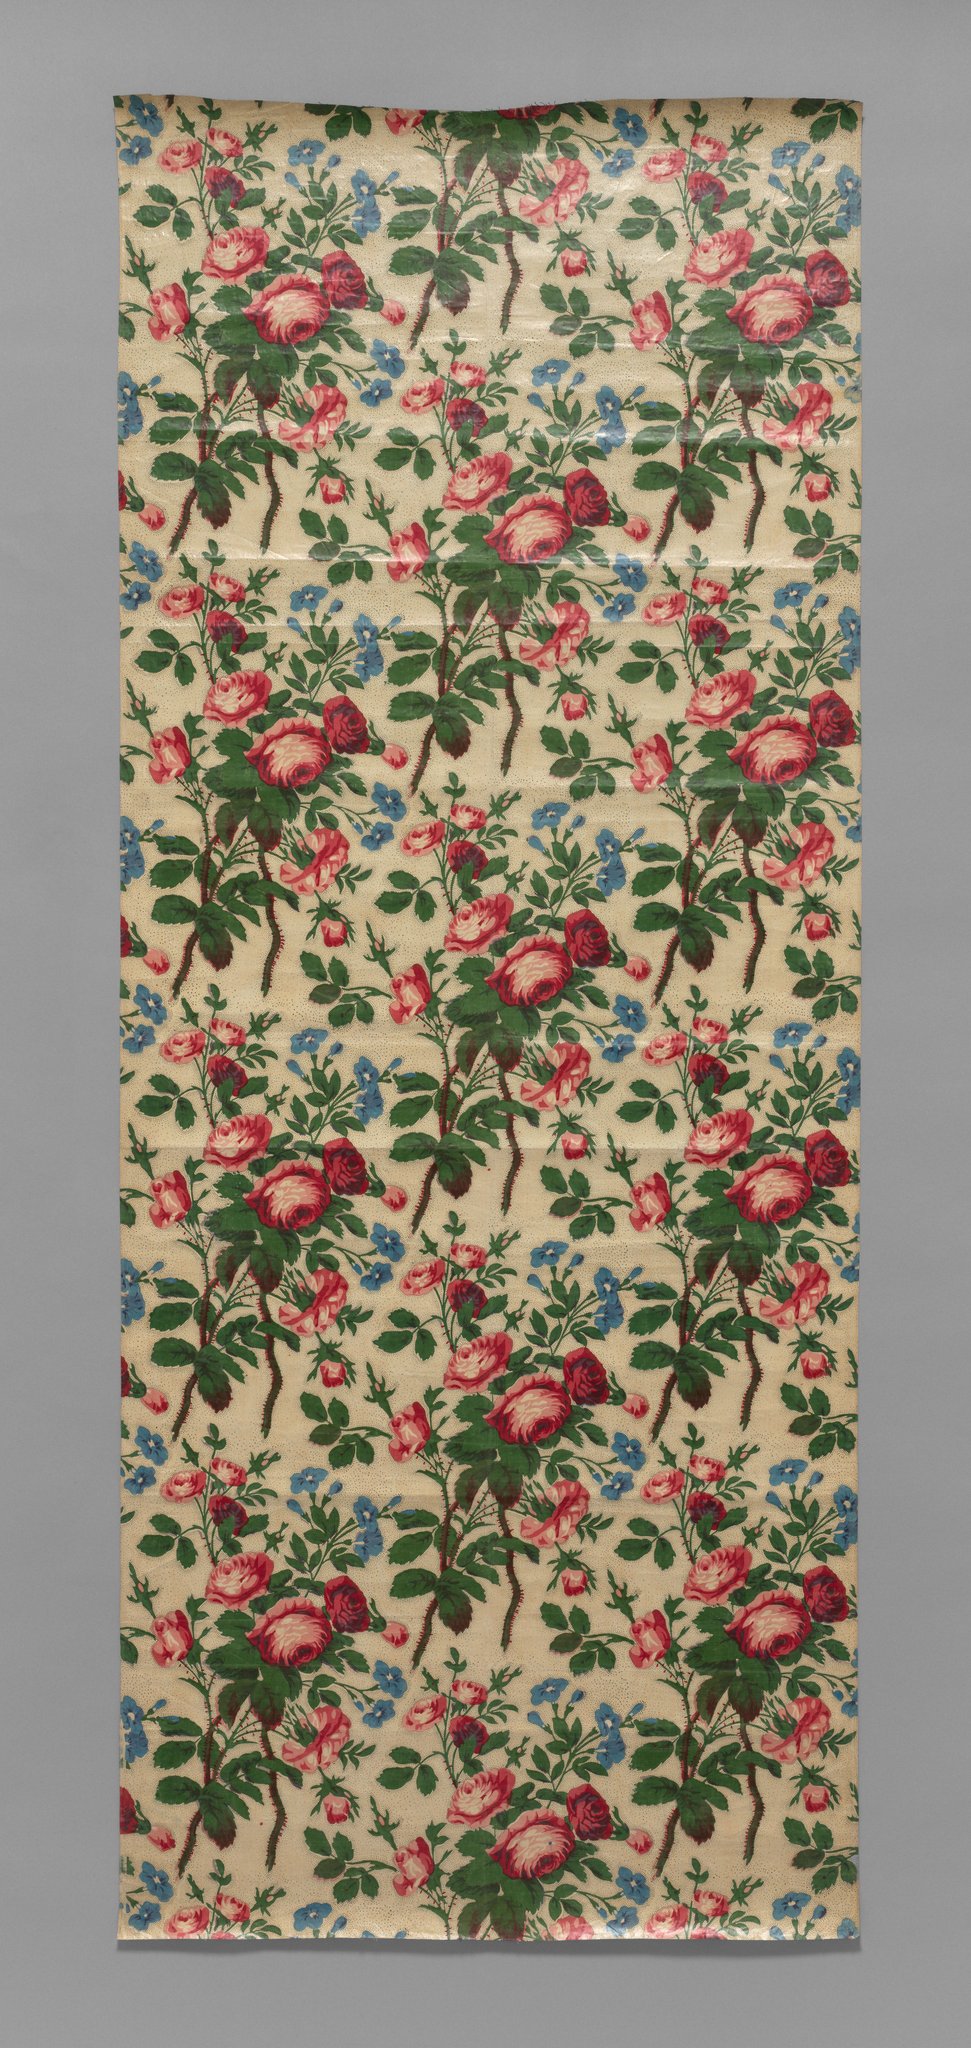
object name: piece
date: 1872-1886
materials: cotton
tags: roses